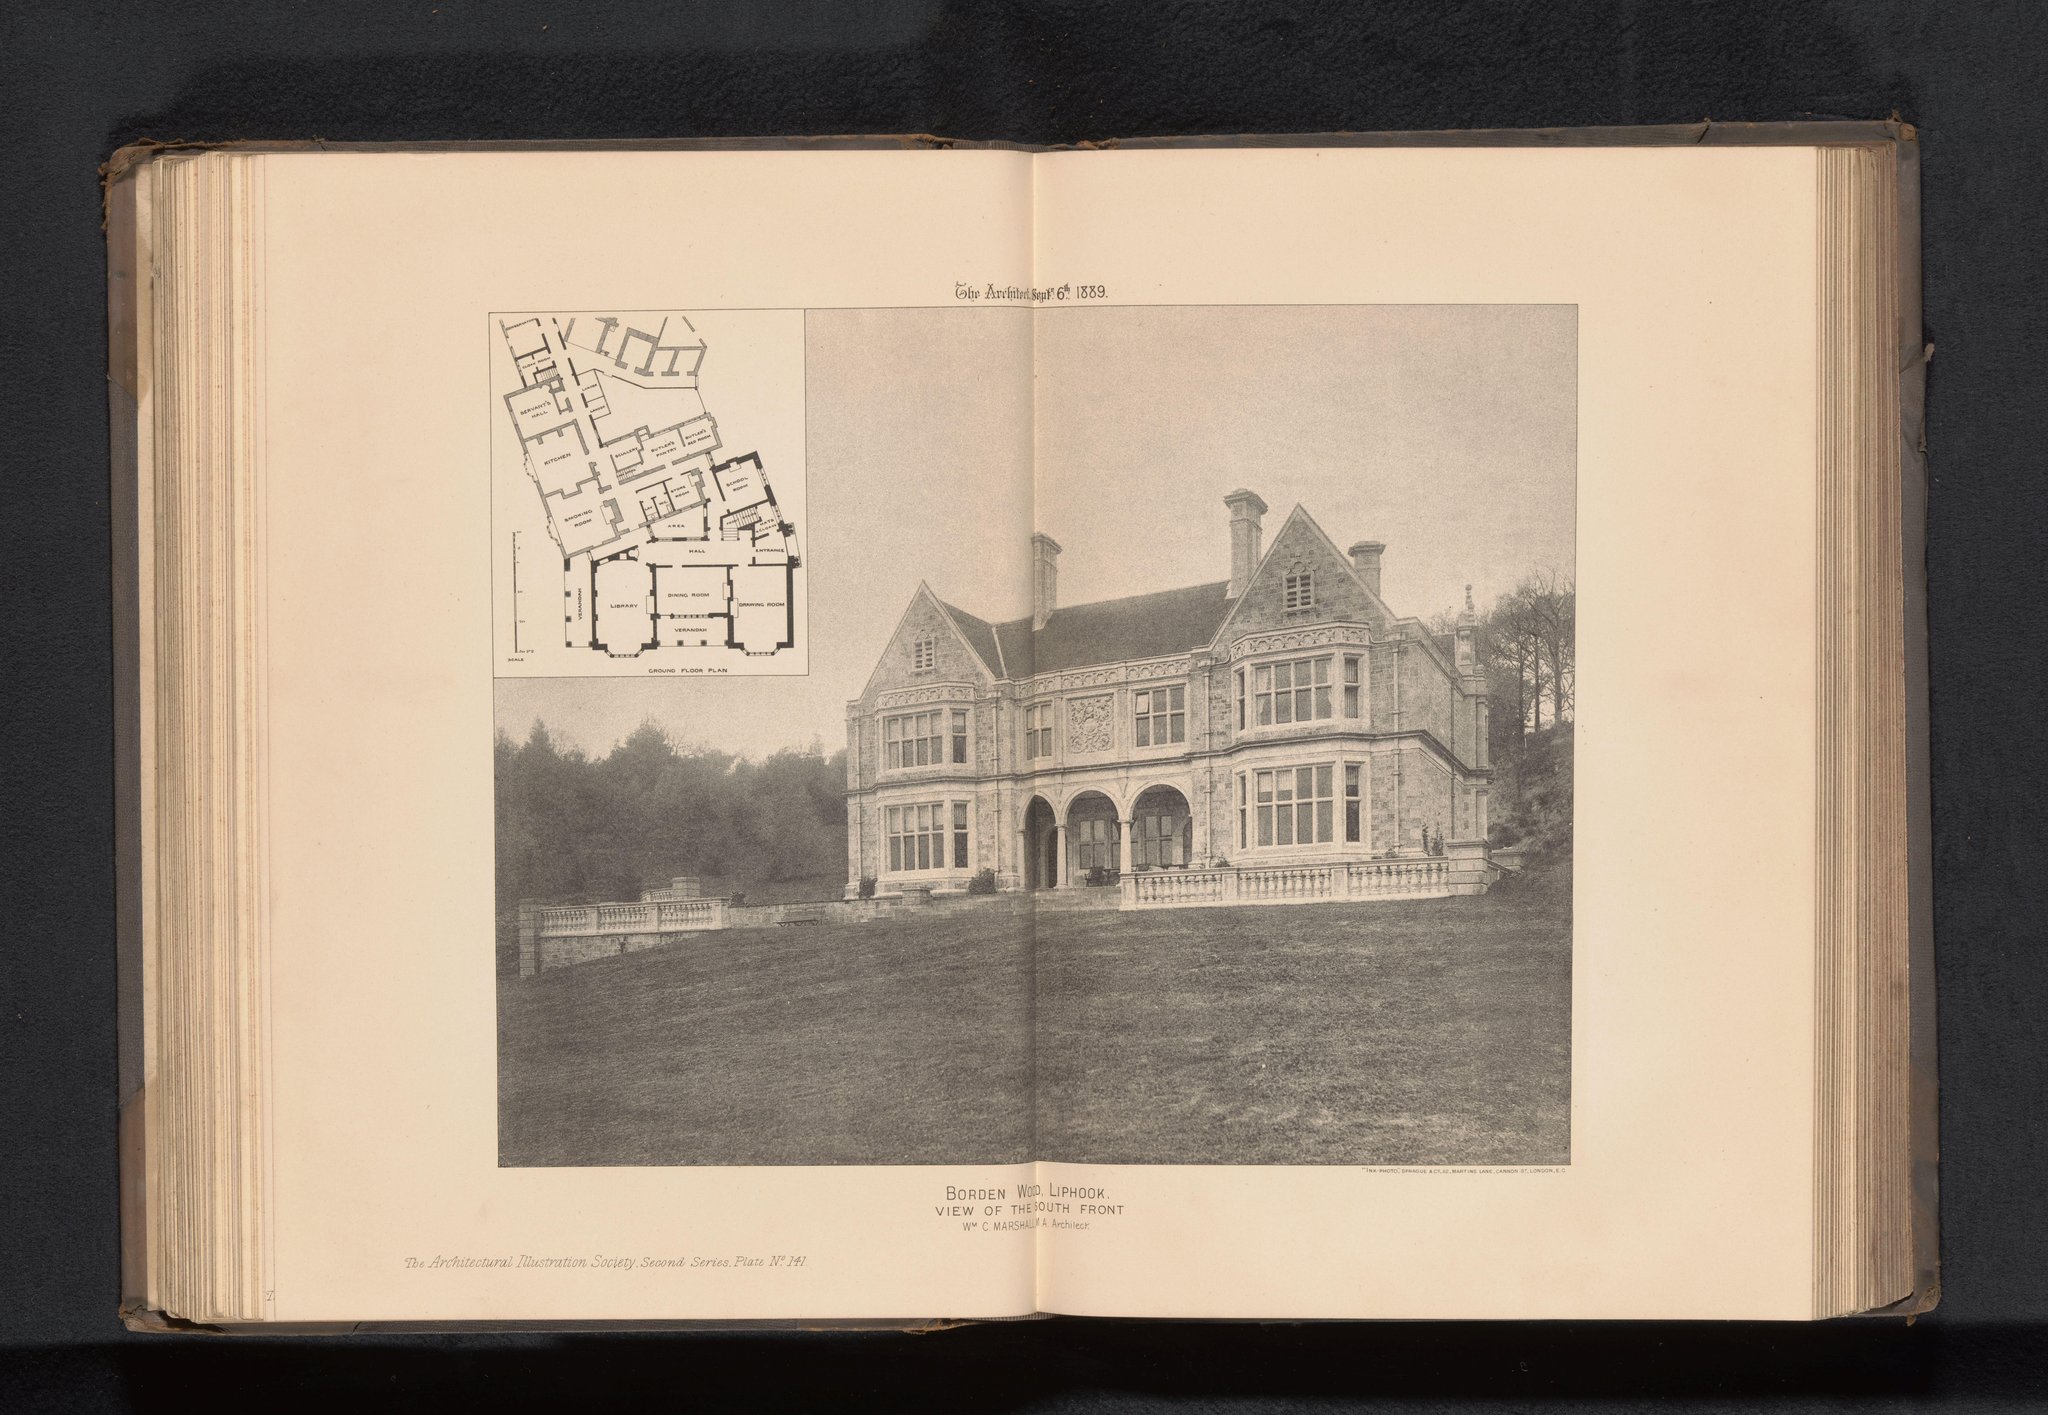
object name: page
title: Gezicht op het Borden Wood House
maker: Anonymous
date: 1884-1889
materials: paper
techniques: photolithography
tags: villa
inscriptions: inscription: ‘Wm C. Marshall, M.A. Architect/ The Architectural Illustration Society. Second Series. Plate No.141’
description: Prent op zesde ongenummerde pagina na pagina 134.